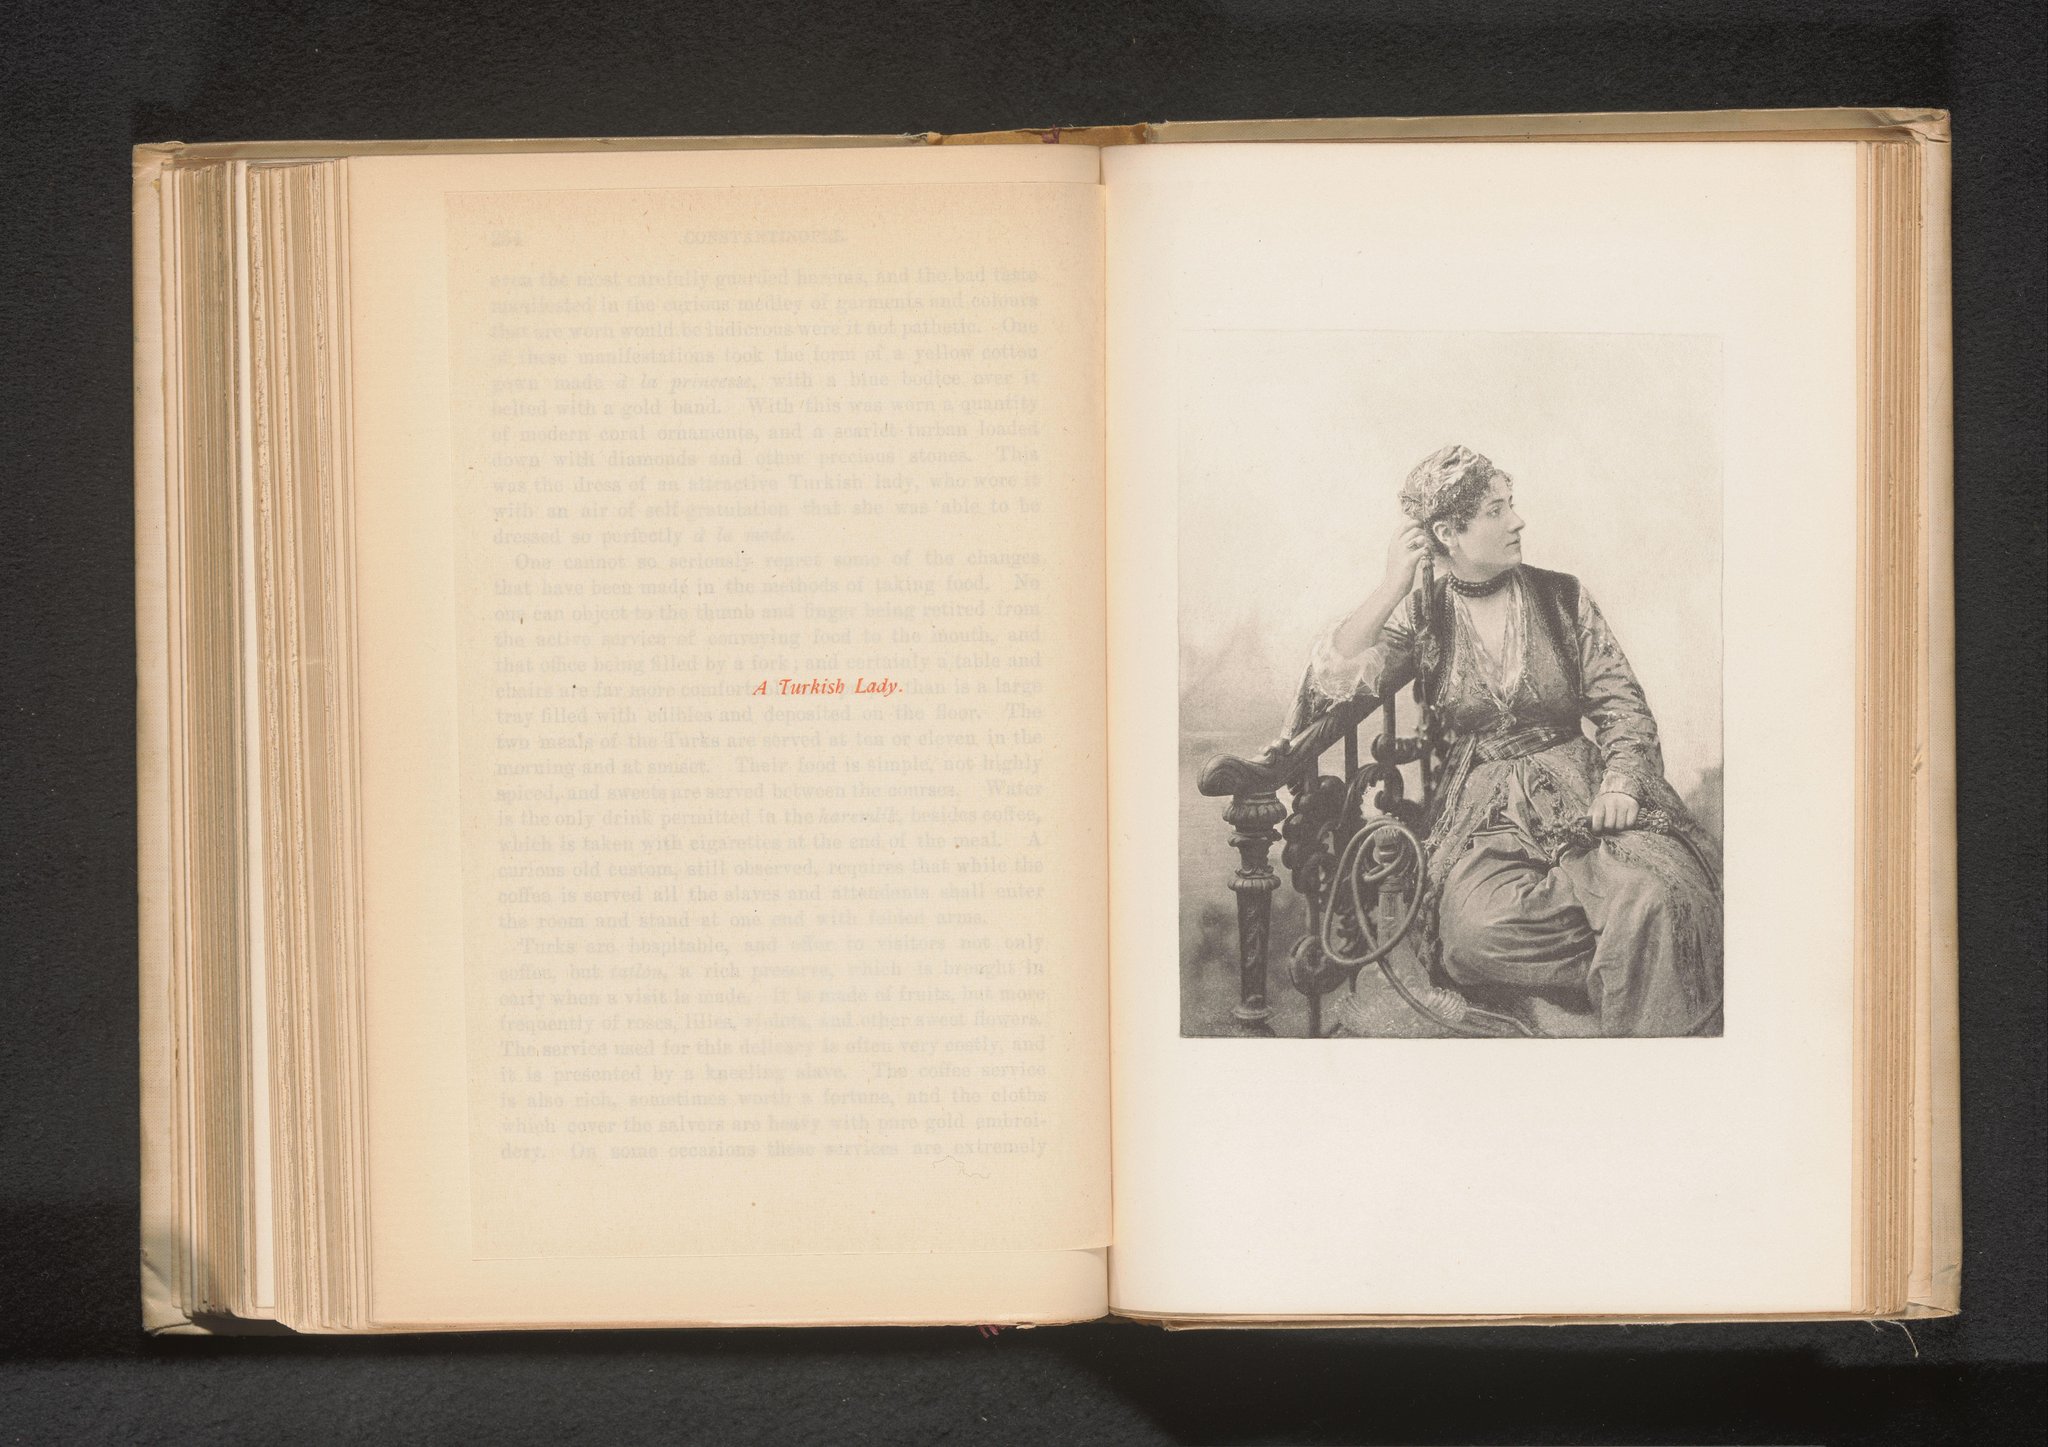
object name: page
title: Portret van een onbekende vrouw met een waterpijp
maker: Anonymous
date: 1885-1895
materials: paper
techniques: photoaquatint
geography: constantinople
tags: water-pipe, hookah, narghile, adult woman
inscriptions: title: ‘A Turkish Lady.’